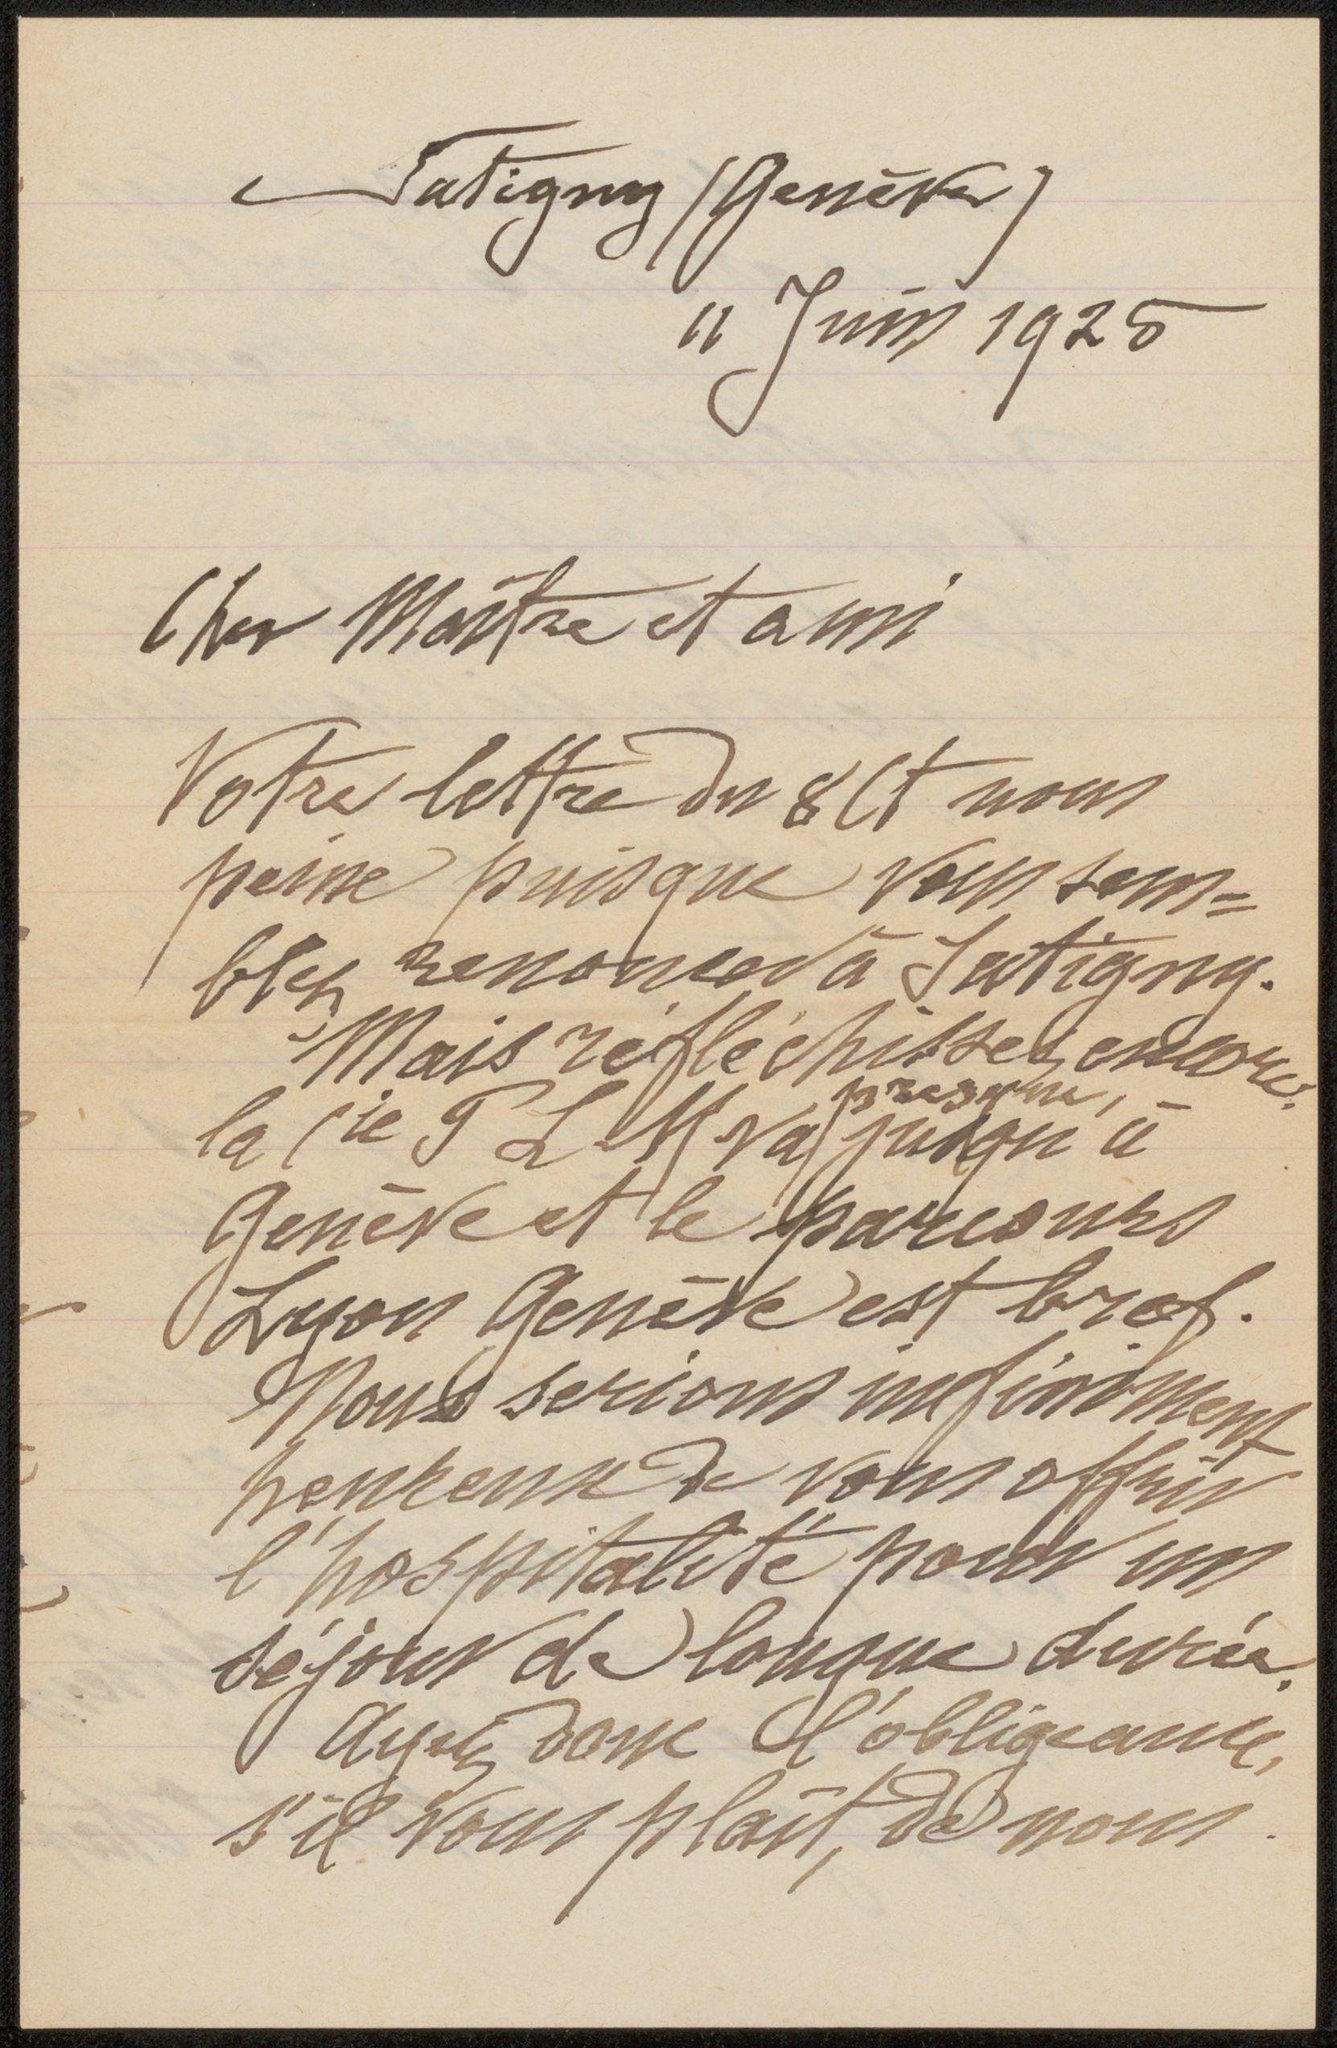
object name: letter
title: Brief aan Philip Zilcken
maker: alphonse stengelin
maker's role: painter, print maker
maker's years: 1852-1938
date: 1925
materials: ink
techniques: pen, writing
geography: satigny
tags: amsterdam, hendrik petrus berlage, the hague, painter, philip zilcken, painting (including book-illumination, miniature-painting), printed matter, netherlands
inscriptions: collector's mark: ‘RPK’